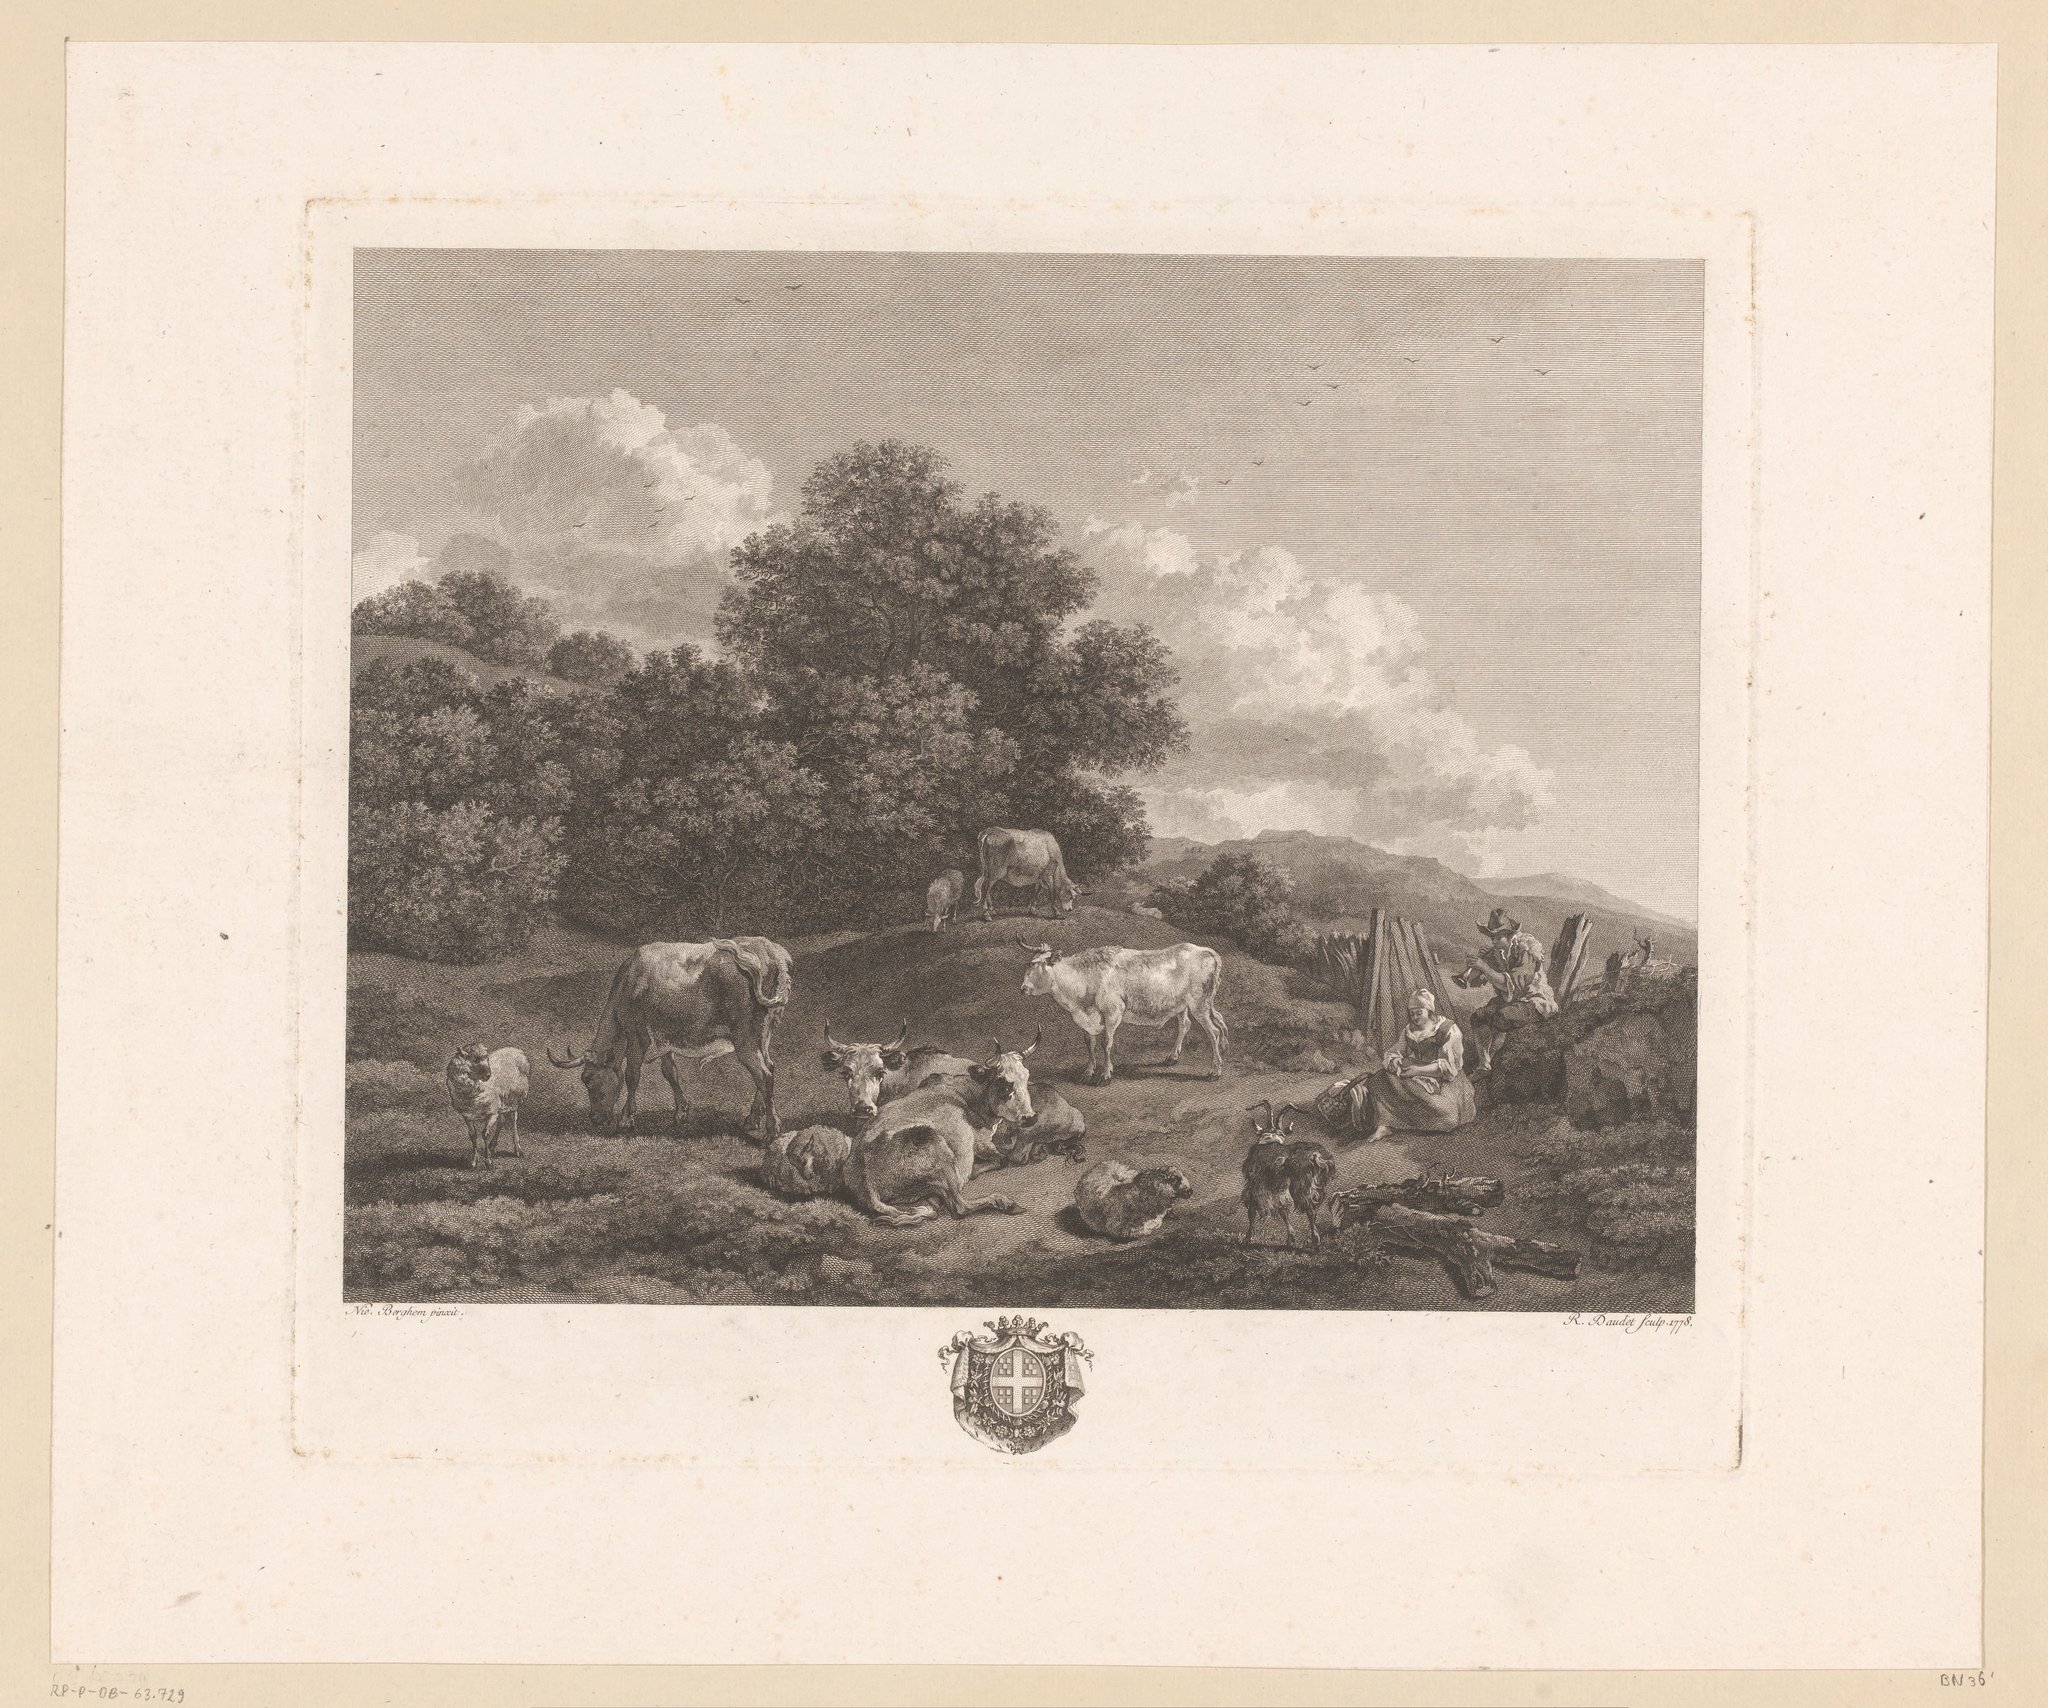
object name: print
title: Landschap met herders en vee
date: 1778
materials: paper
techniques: engraving, etching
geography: france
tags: landscapes, herding, herdsman, herdswoman, shepherd, shepherdess, cowherd, etc., herd, flock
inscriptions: collector's mark: Lugt 240